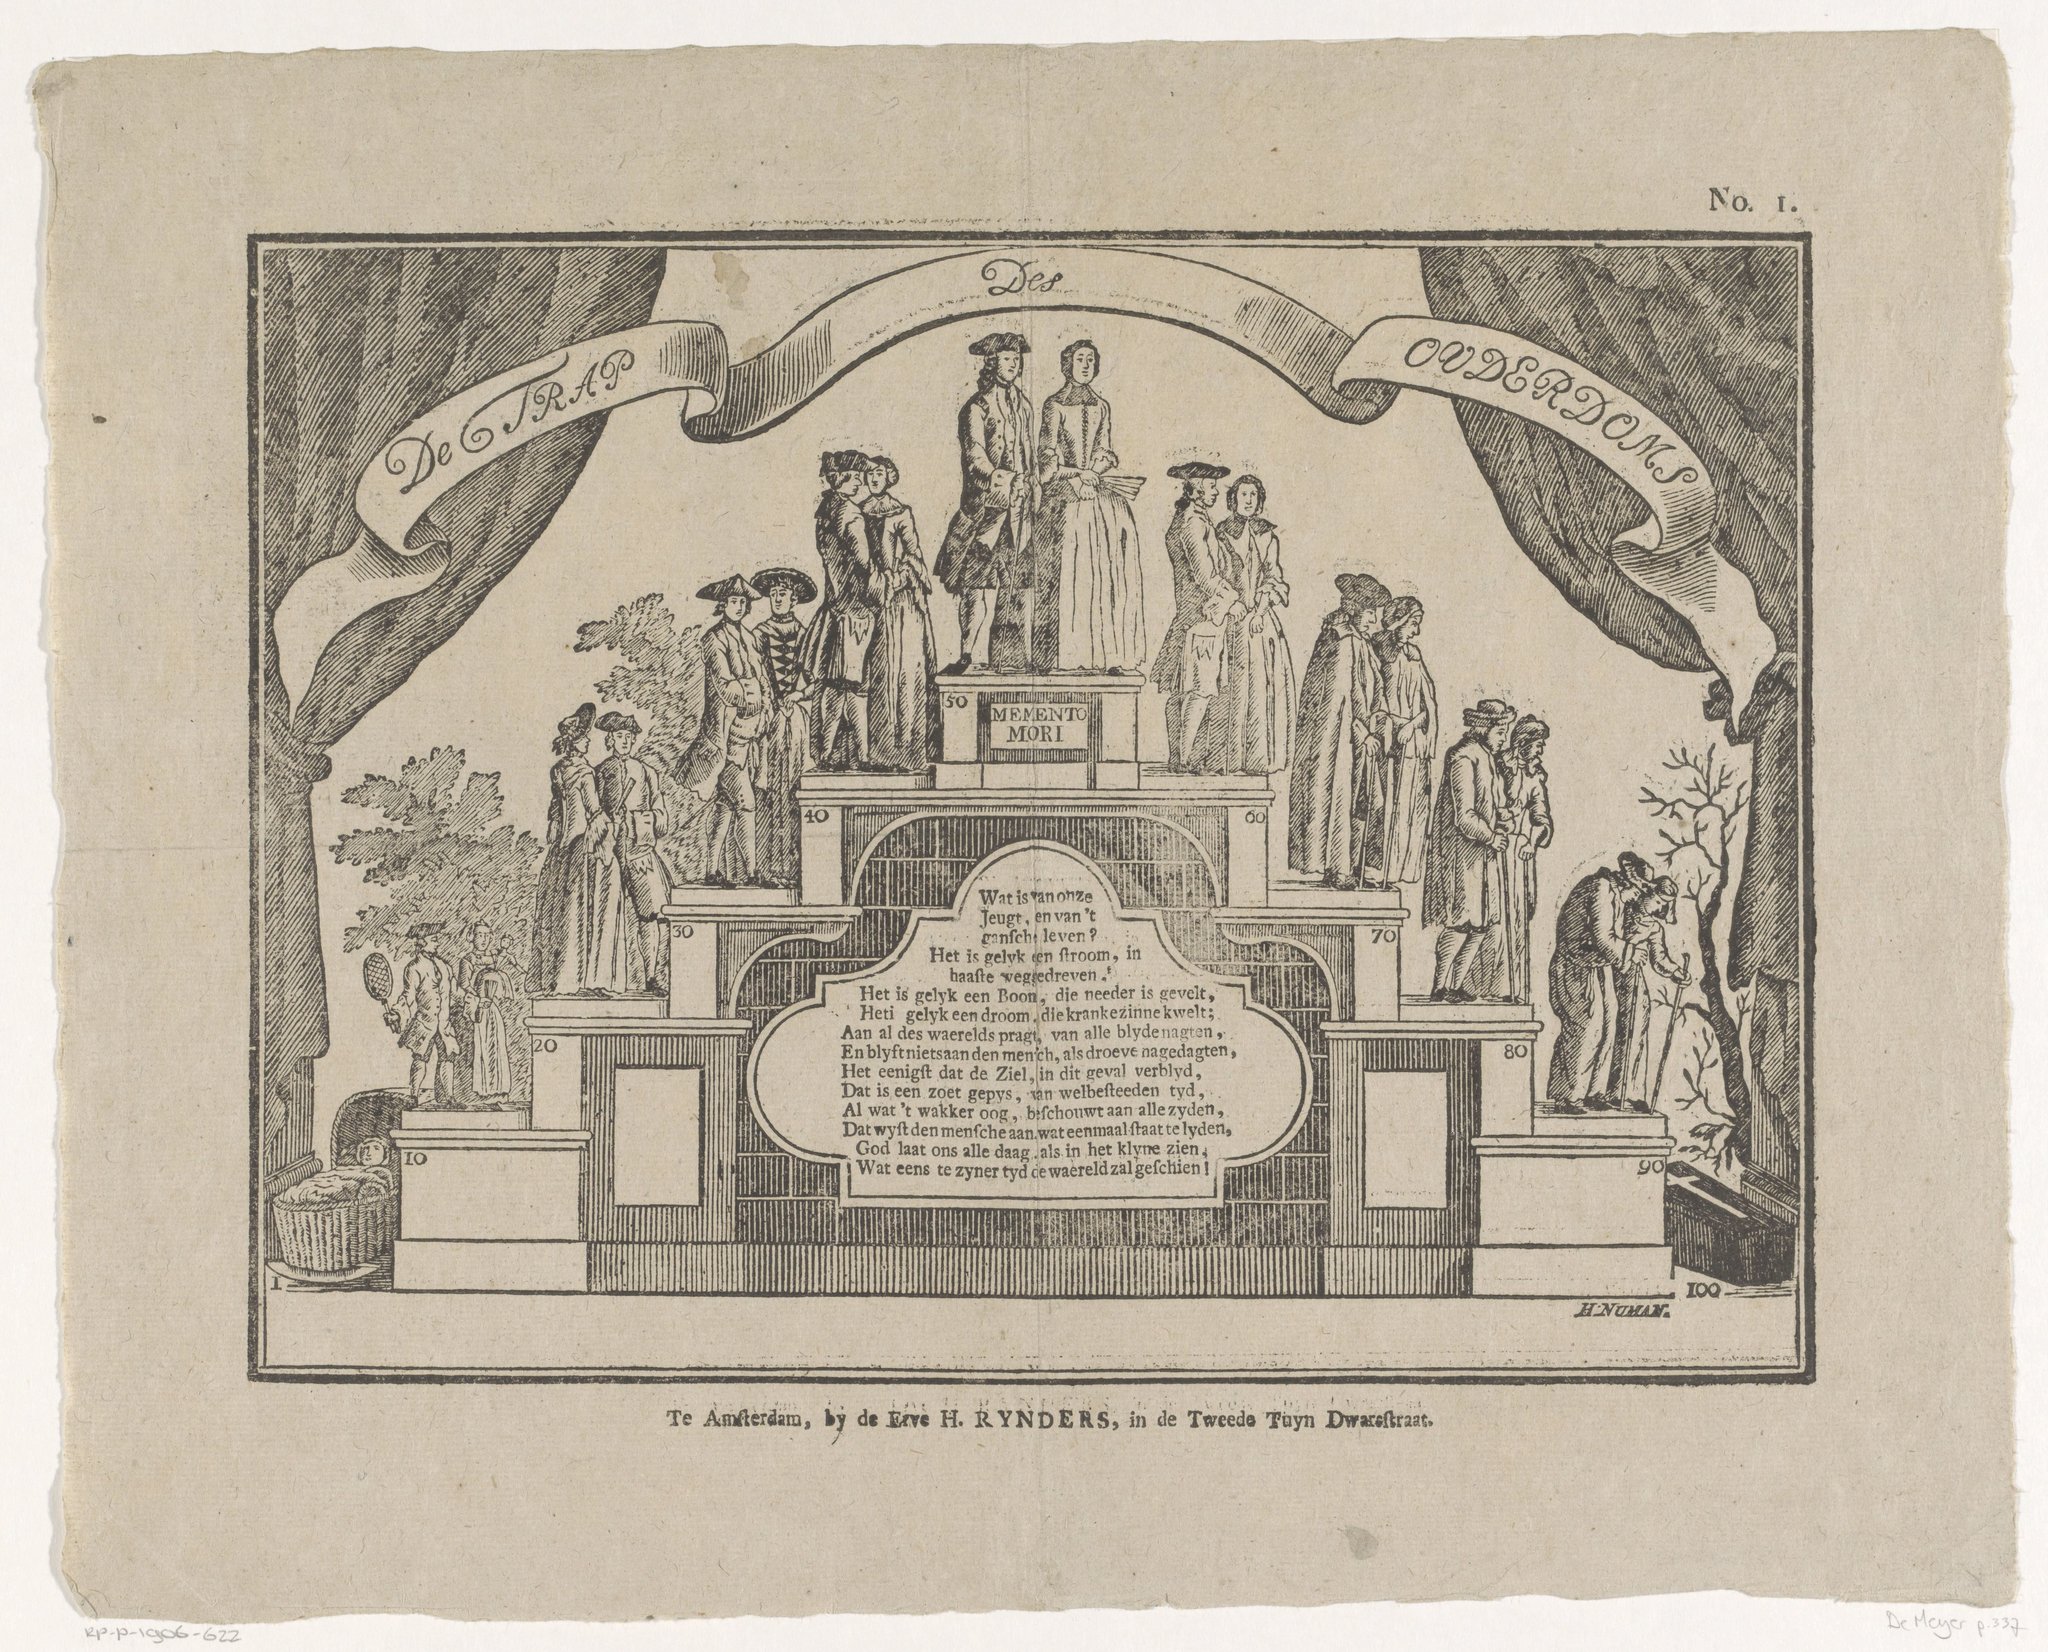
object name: print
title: De trap des ouderdoms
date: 1831-1854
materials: paper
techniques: letterpress printing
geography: haarlem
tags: the ages of man represented by a staircase, human life divided into stages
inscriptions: collector's mark: Lugt 2228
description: Een trap des ouderdoms: een parentrap. Op de treden van de trap, in de vorm van een brug, staan mannen en vrouwen in de leeftijd van 0 tot 100 jaar. Onder de brug een cartouche met vers. Aan weerszijden van de voorstelling een gordijn. Genummerd rechtsboven: No. 1.